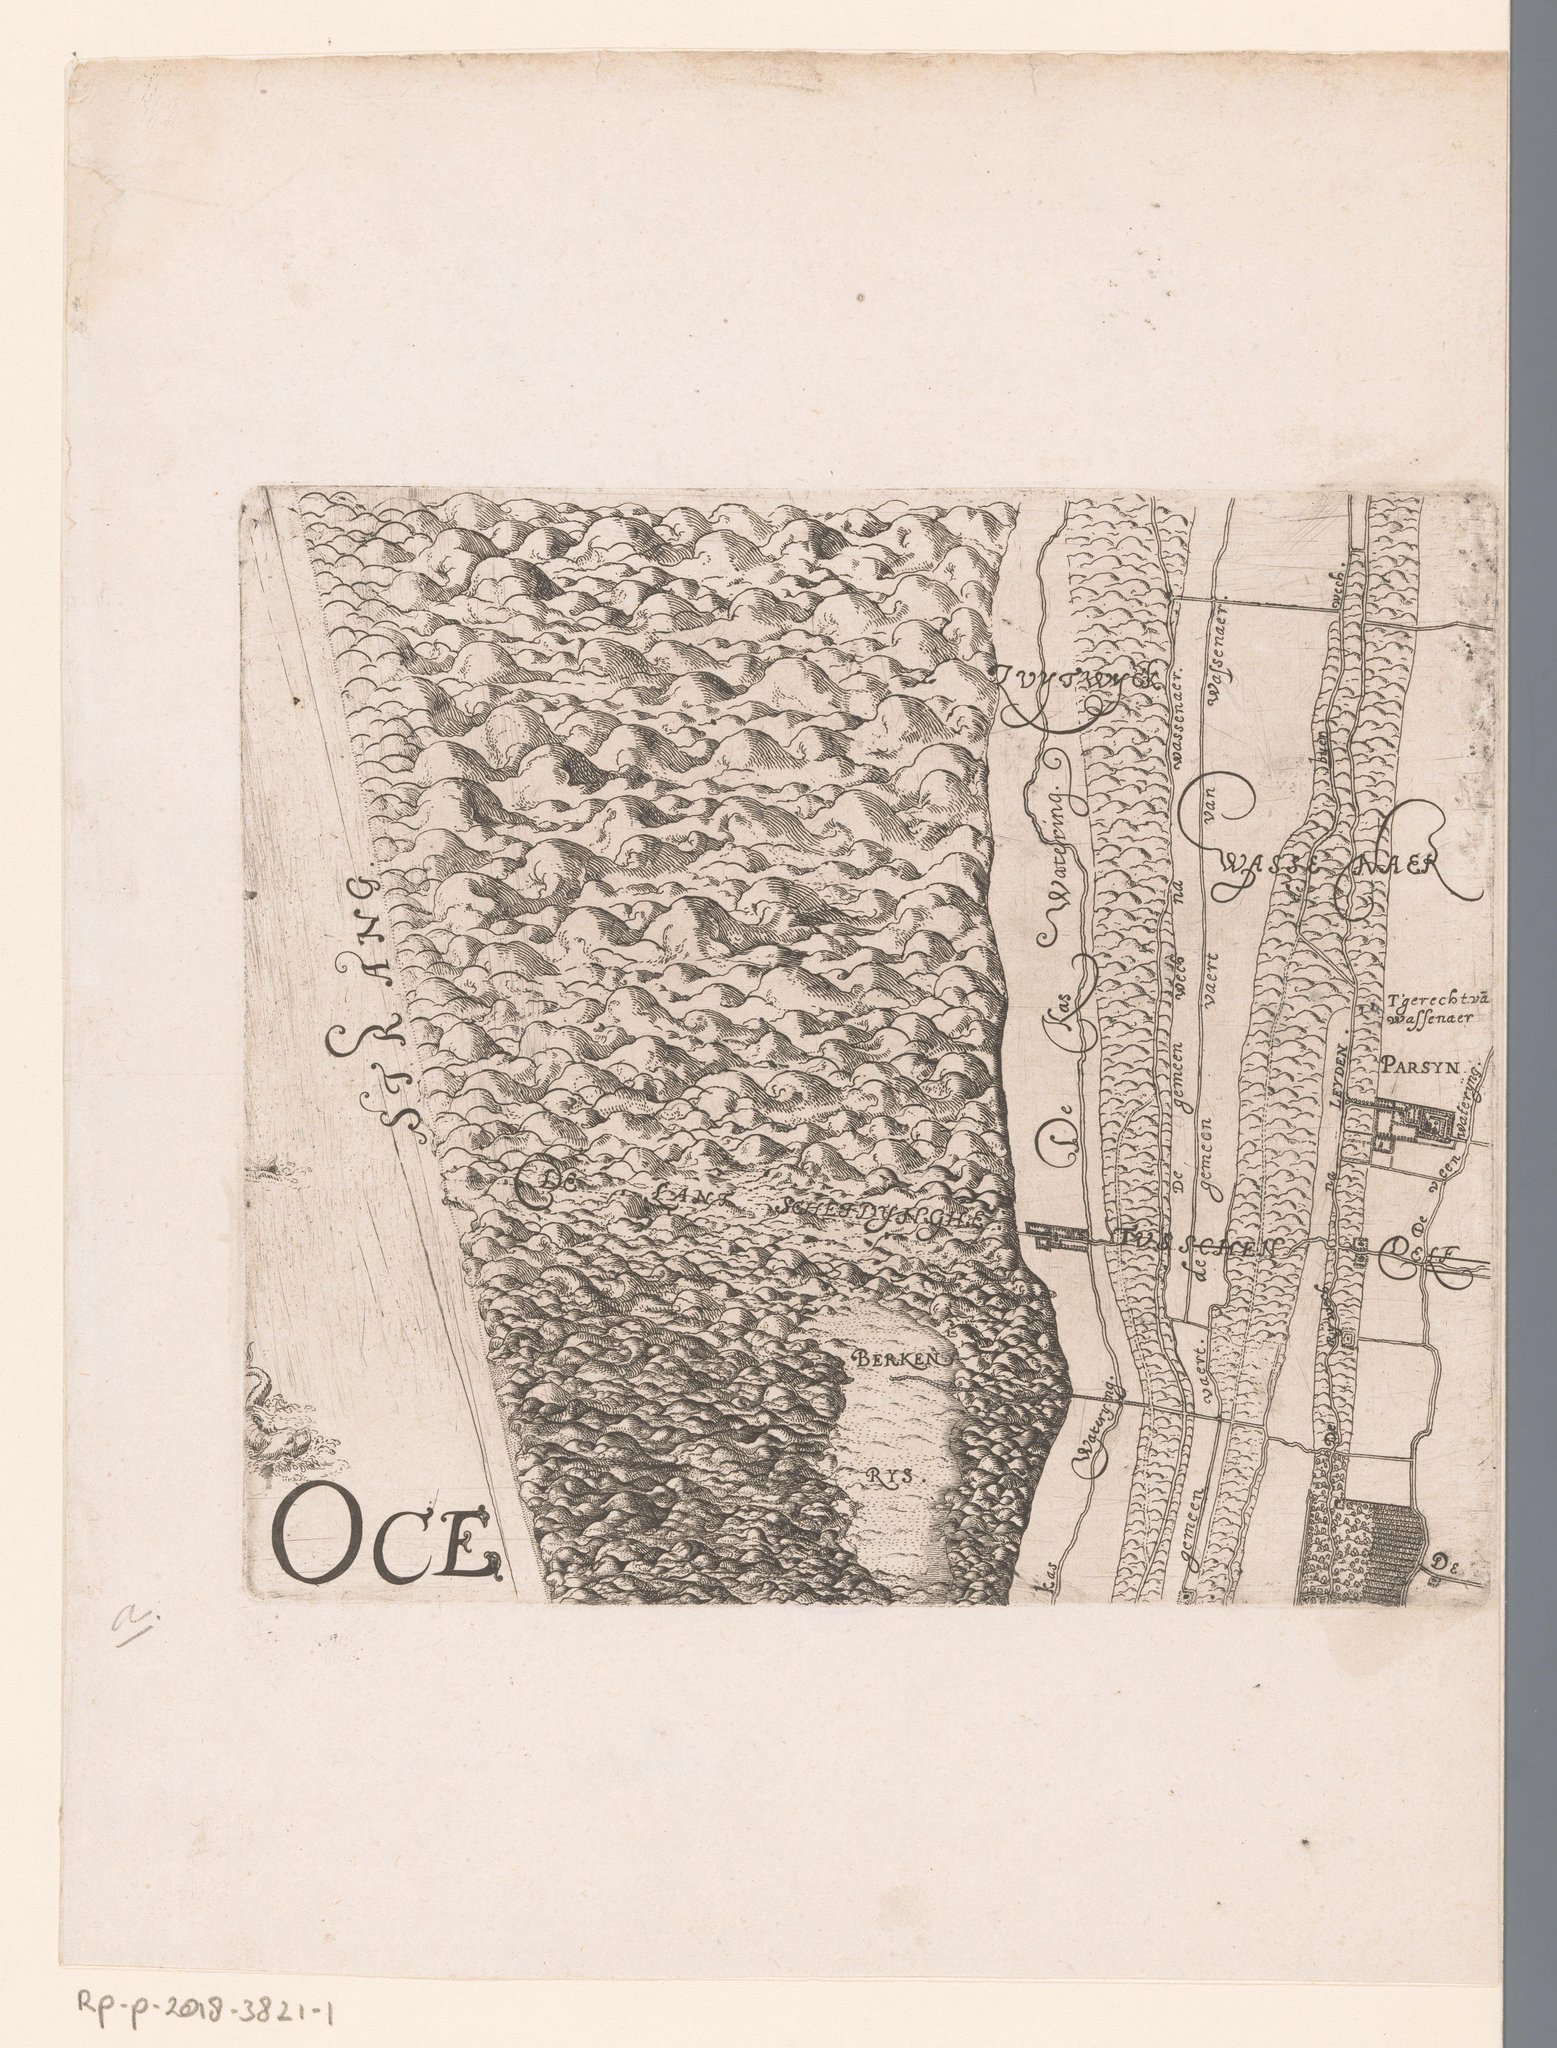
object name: map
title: Kaart van het Hoogheemraadschap van Delfland, met Wassenaar en omgeving, deel linksboven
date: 1611-1692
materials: paper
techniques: engraving, etching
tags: maps of separate countries or regions